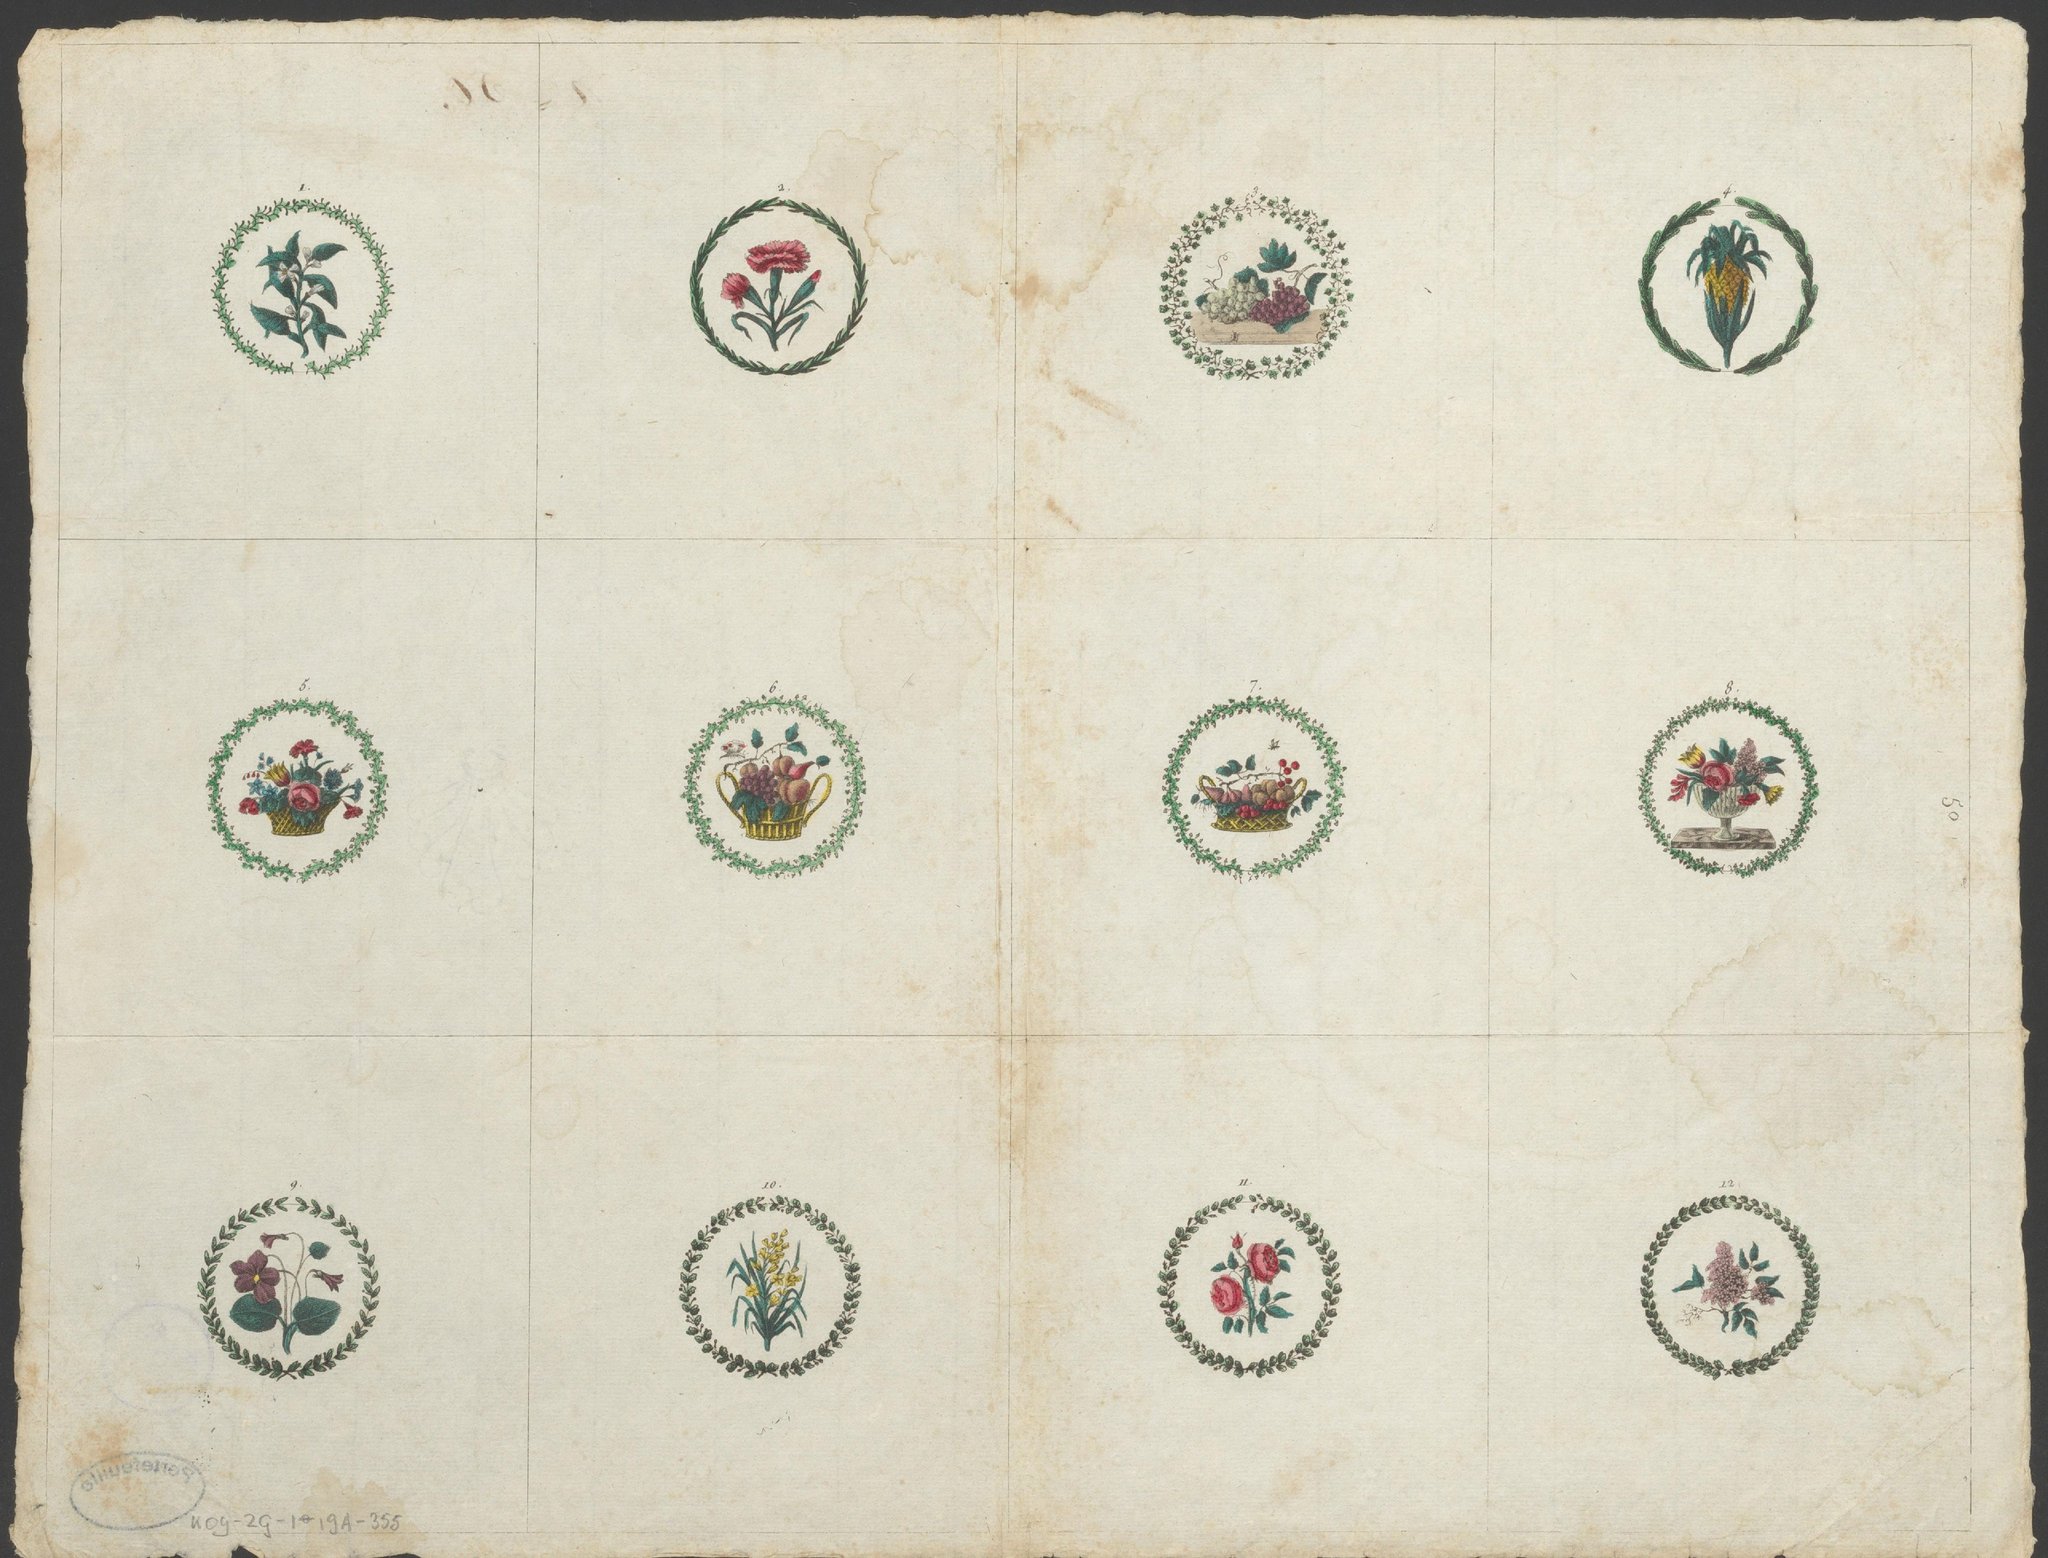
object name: print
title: Vruchten en bloemen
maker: Anonymous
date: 1800-1899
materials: paper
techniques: engraving, etching, hand coloring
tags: flowers, fruits: pineapple, container made of plant material other than wood: basket, flowers: rose, grape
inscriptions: collector's mark: Lugt 1641, stamp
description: Twaalf voorstellingen van vruchten en bloemen in drie rijen van vier. In de middelste rij zitten de vruchten en bloemen in een mand. Op verso genummerd: No. 50. Onderwerpsrubrieken binnen de Atlas Zeden en Gewoonten: Zeden en Gewoonten in Engeren Zin, Des menschen beging, midden en einde, Kinderleven – Kinderspel en Kinderprenten.